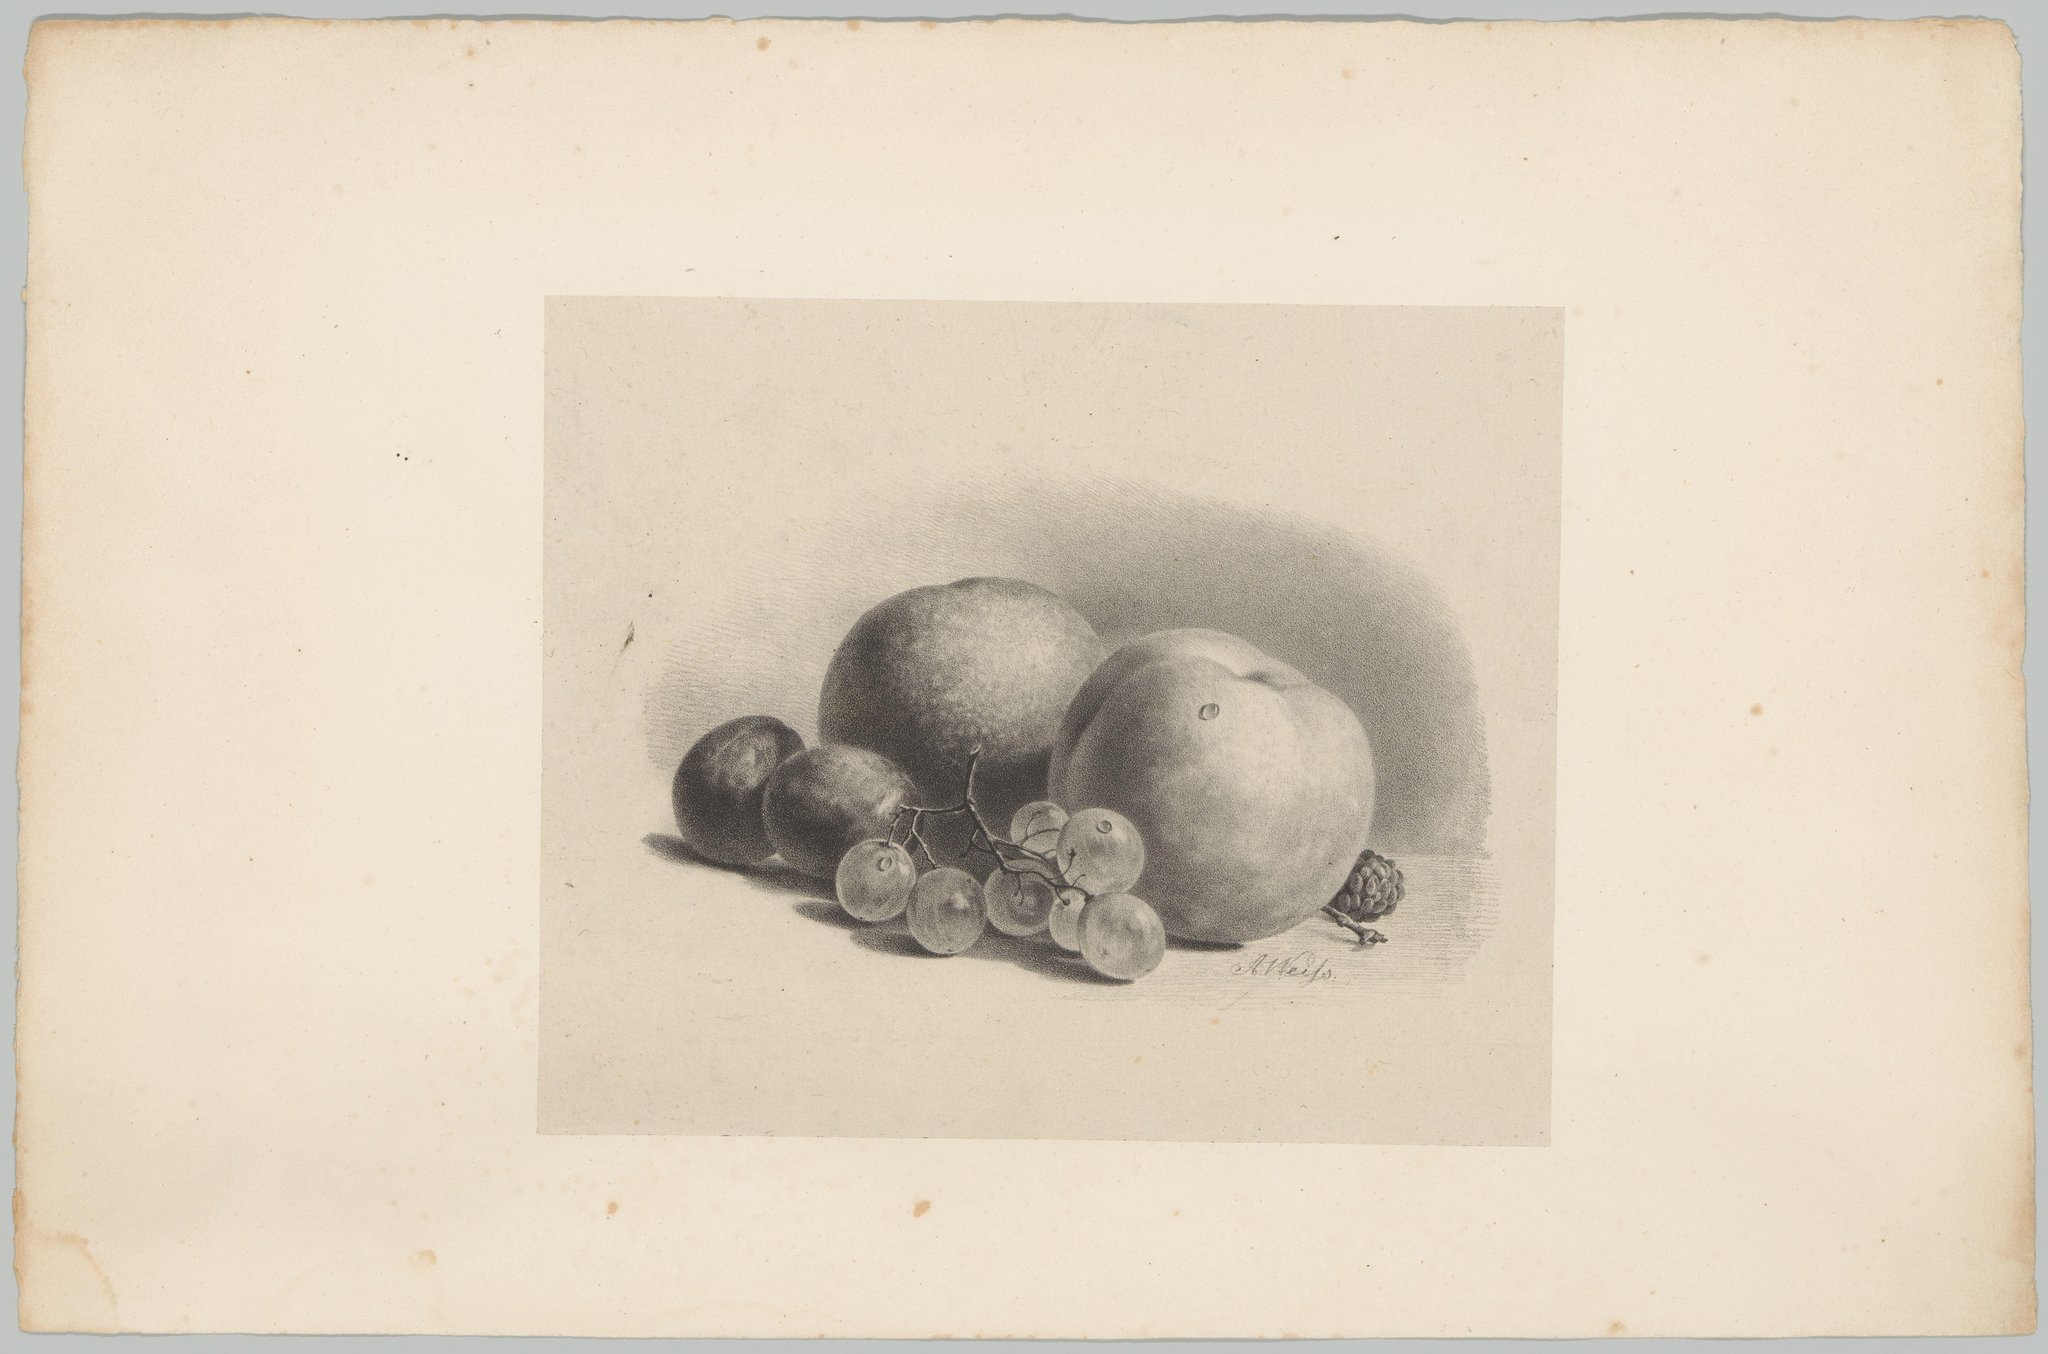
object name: print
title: Perziken, pruimen, druiven en braam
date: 1820-1833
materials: paper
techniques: lithograph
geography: amsterdam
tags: fruits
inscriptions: collector's mark: Lugt 2228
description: Onderdeel van een omslag met in totaal zevenenzeventig lithografieën van bloemen en fruit.